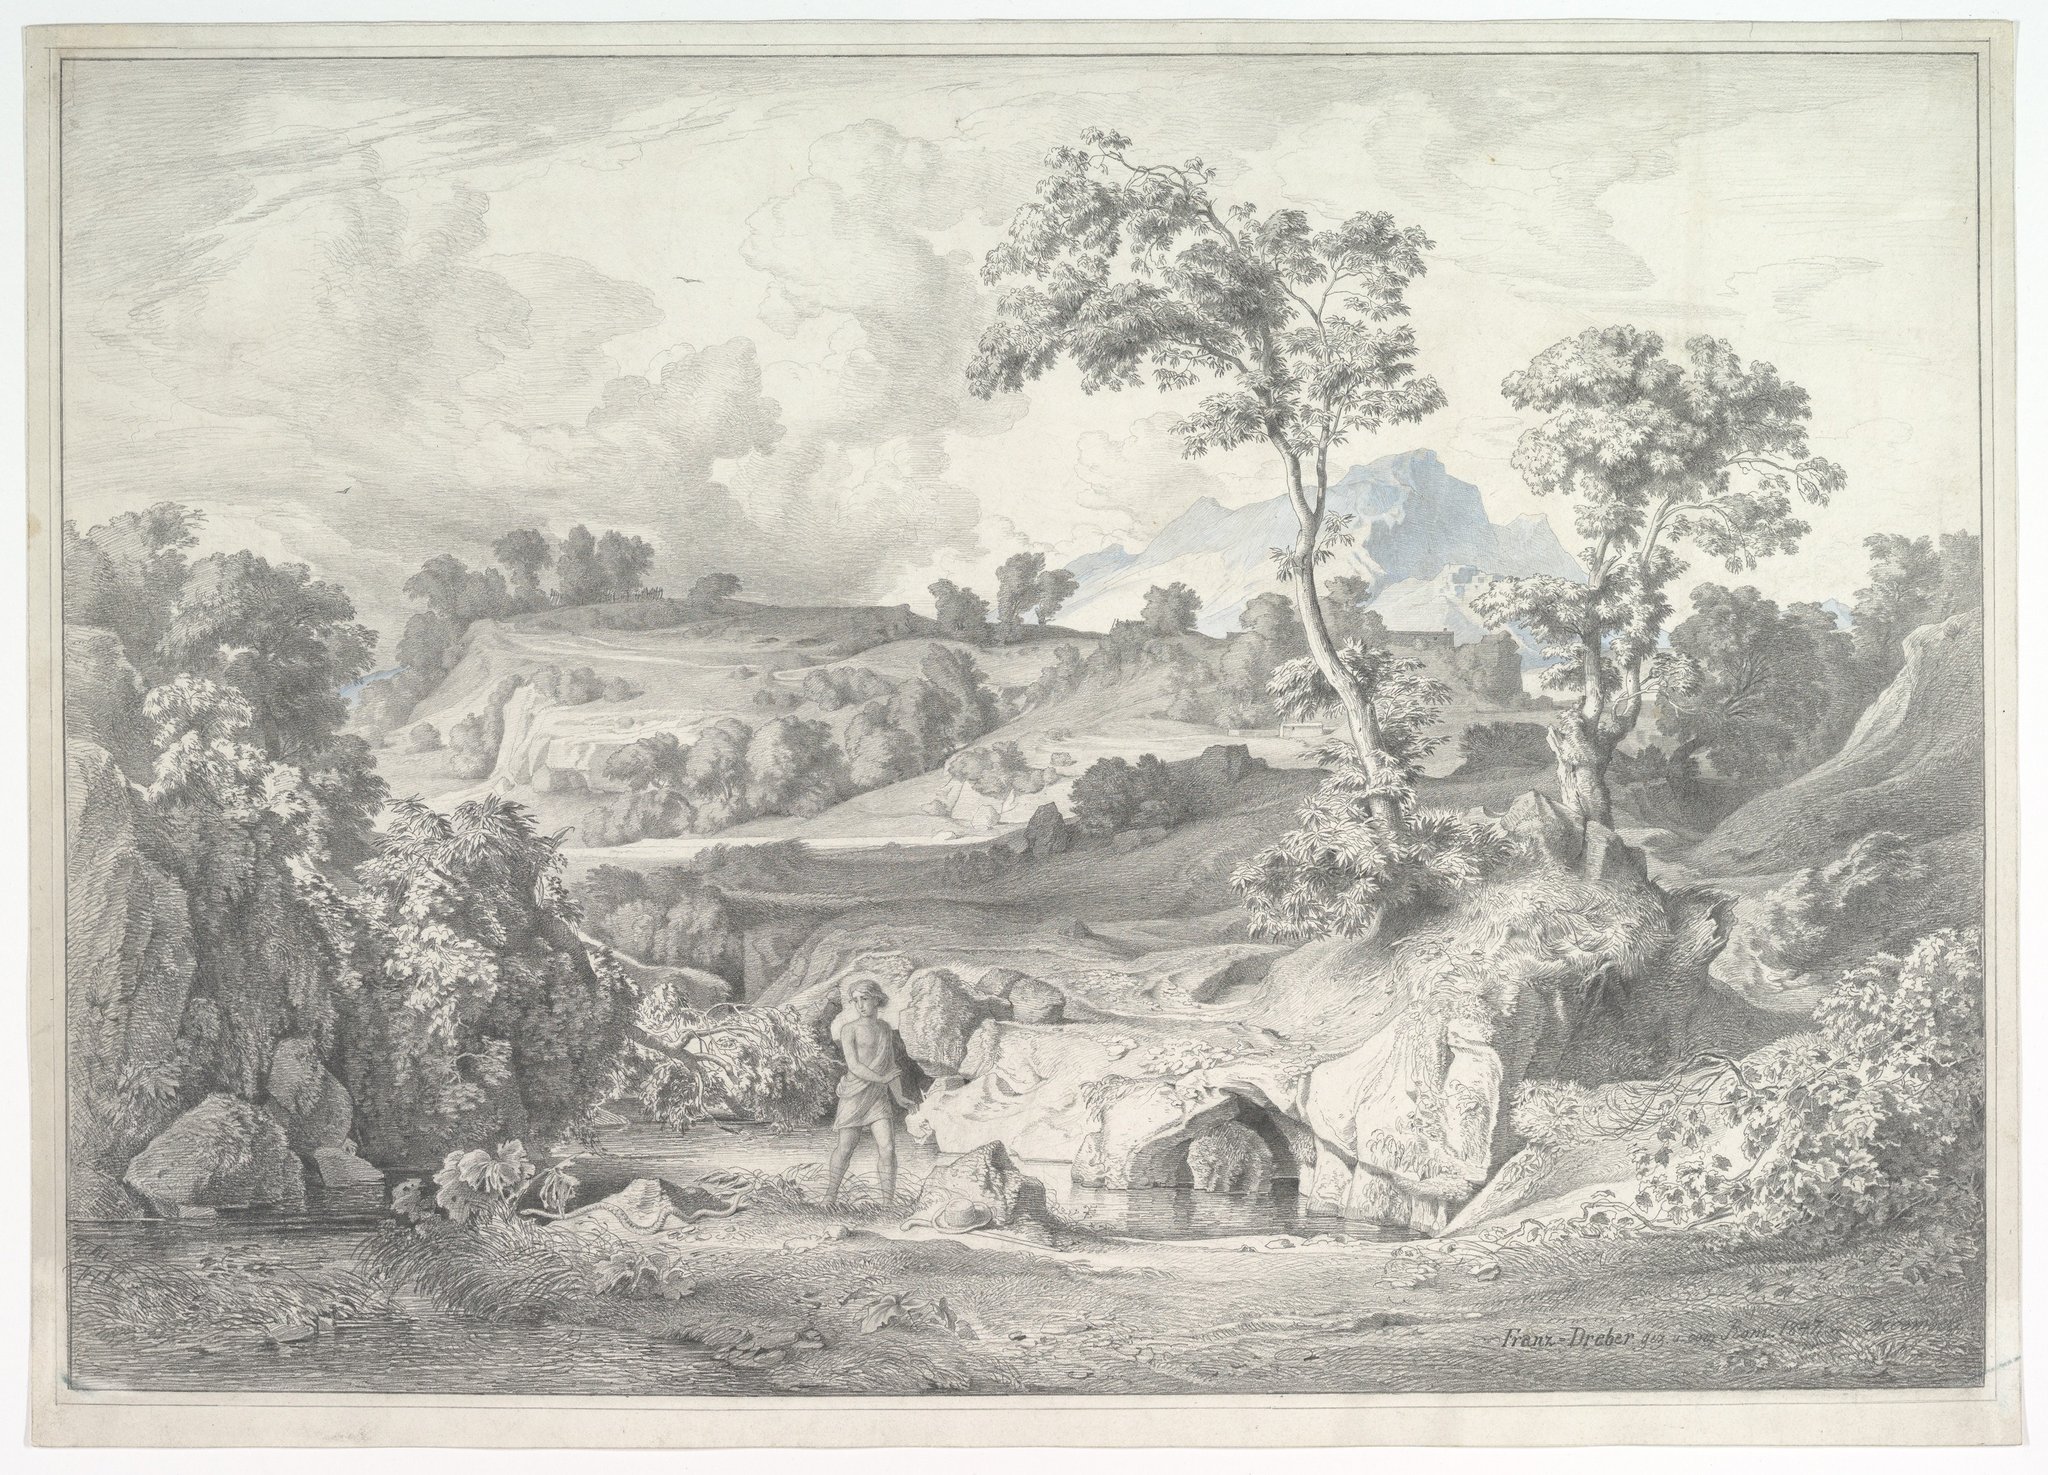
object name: drawing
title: Southern landscape with a man and a snake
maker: heinrich dreber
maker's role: artist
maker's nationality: german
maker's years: 1822-1875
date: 1847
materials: graphite, watercolor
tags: men,snakes,landscapes,trees